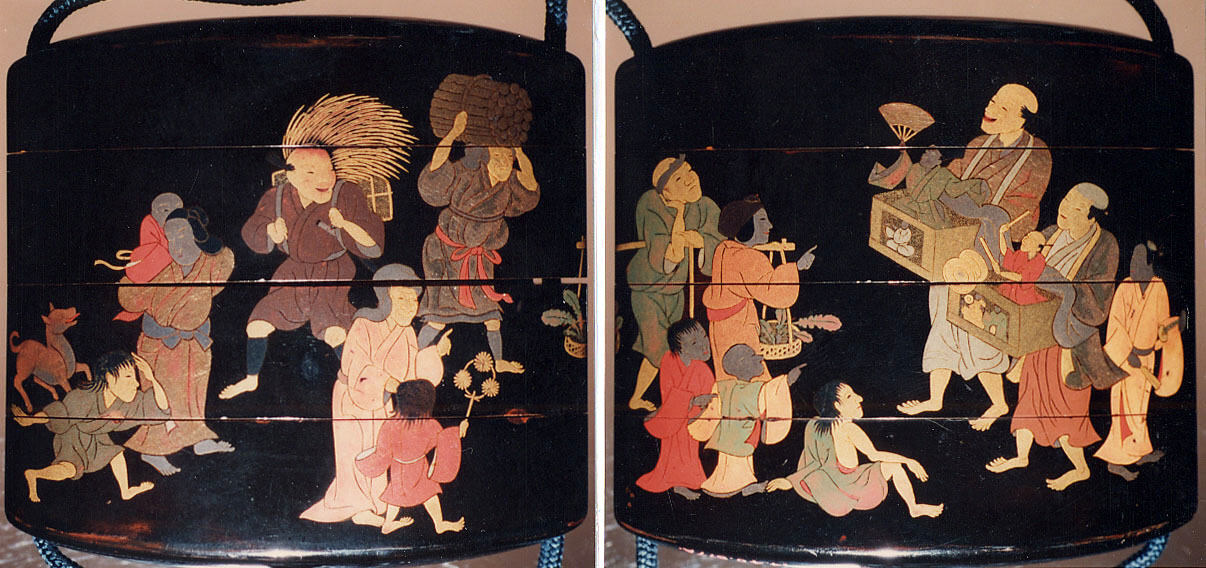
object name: inrō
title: Inrō with Street Festival (obverse); People Watching a Puppet Show (reverse)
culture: japanese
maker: tatsuke takamasu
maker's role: artist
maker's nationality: japanese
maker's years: 1750-1799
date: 1751-1800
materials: gold, lacquer, silver, wood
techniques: carving, lacquer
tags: performance,boys,men,women,spectators,dogs,puppets